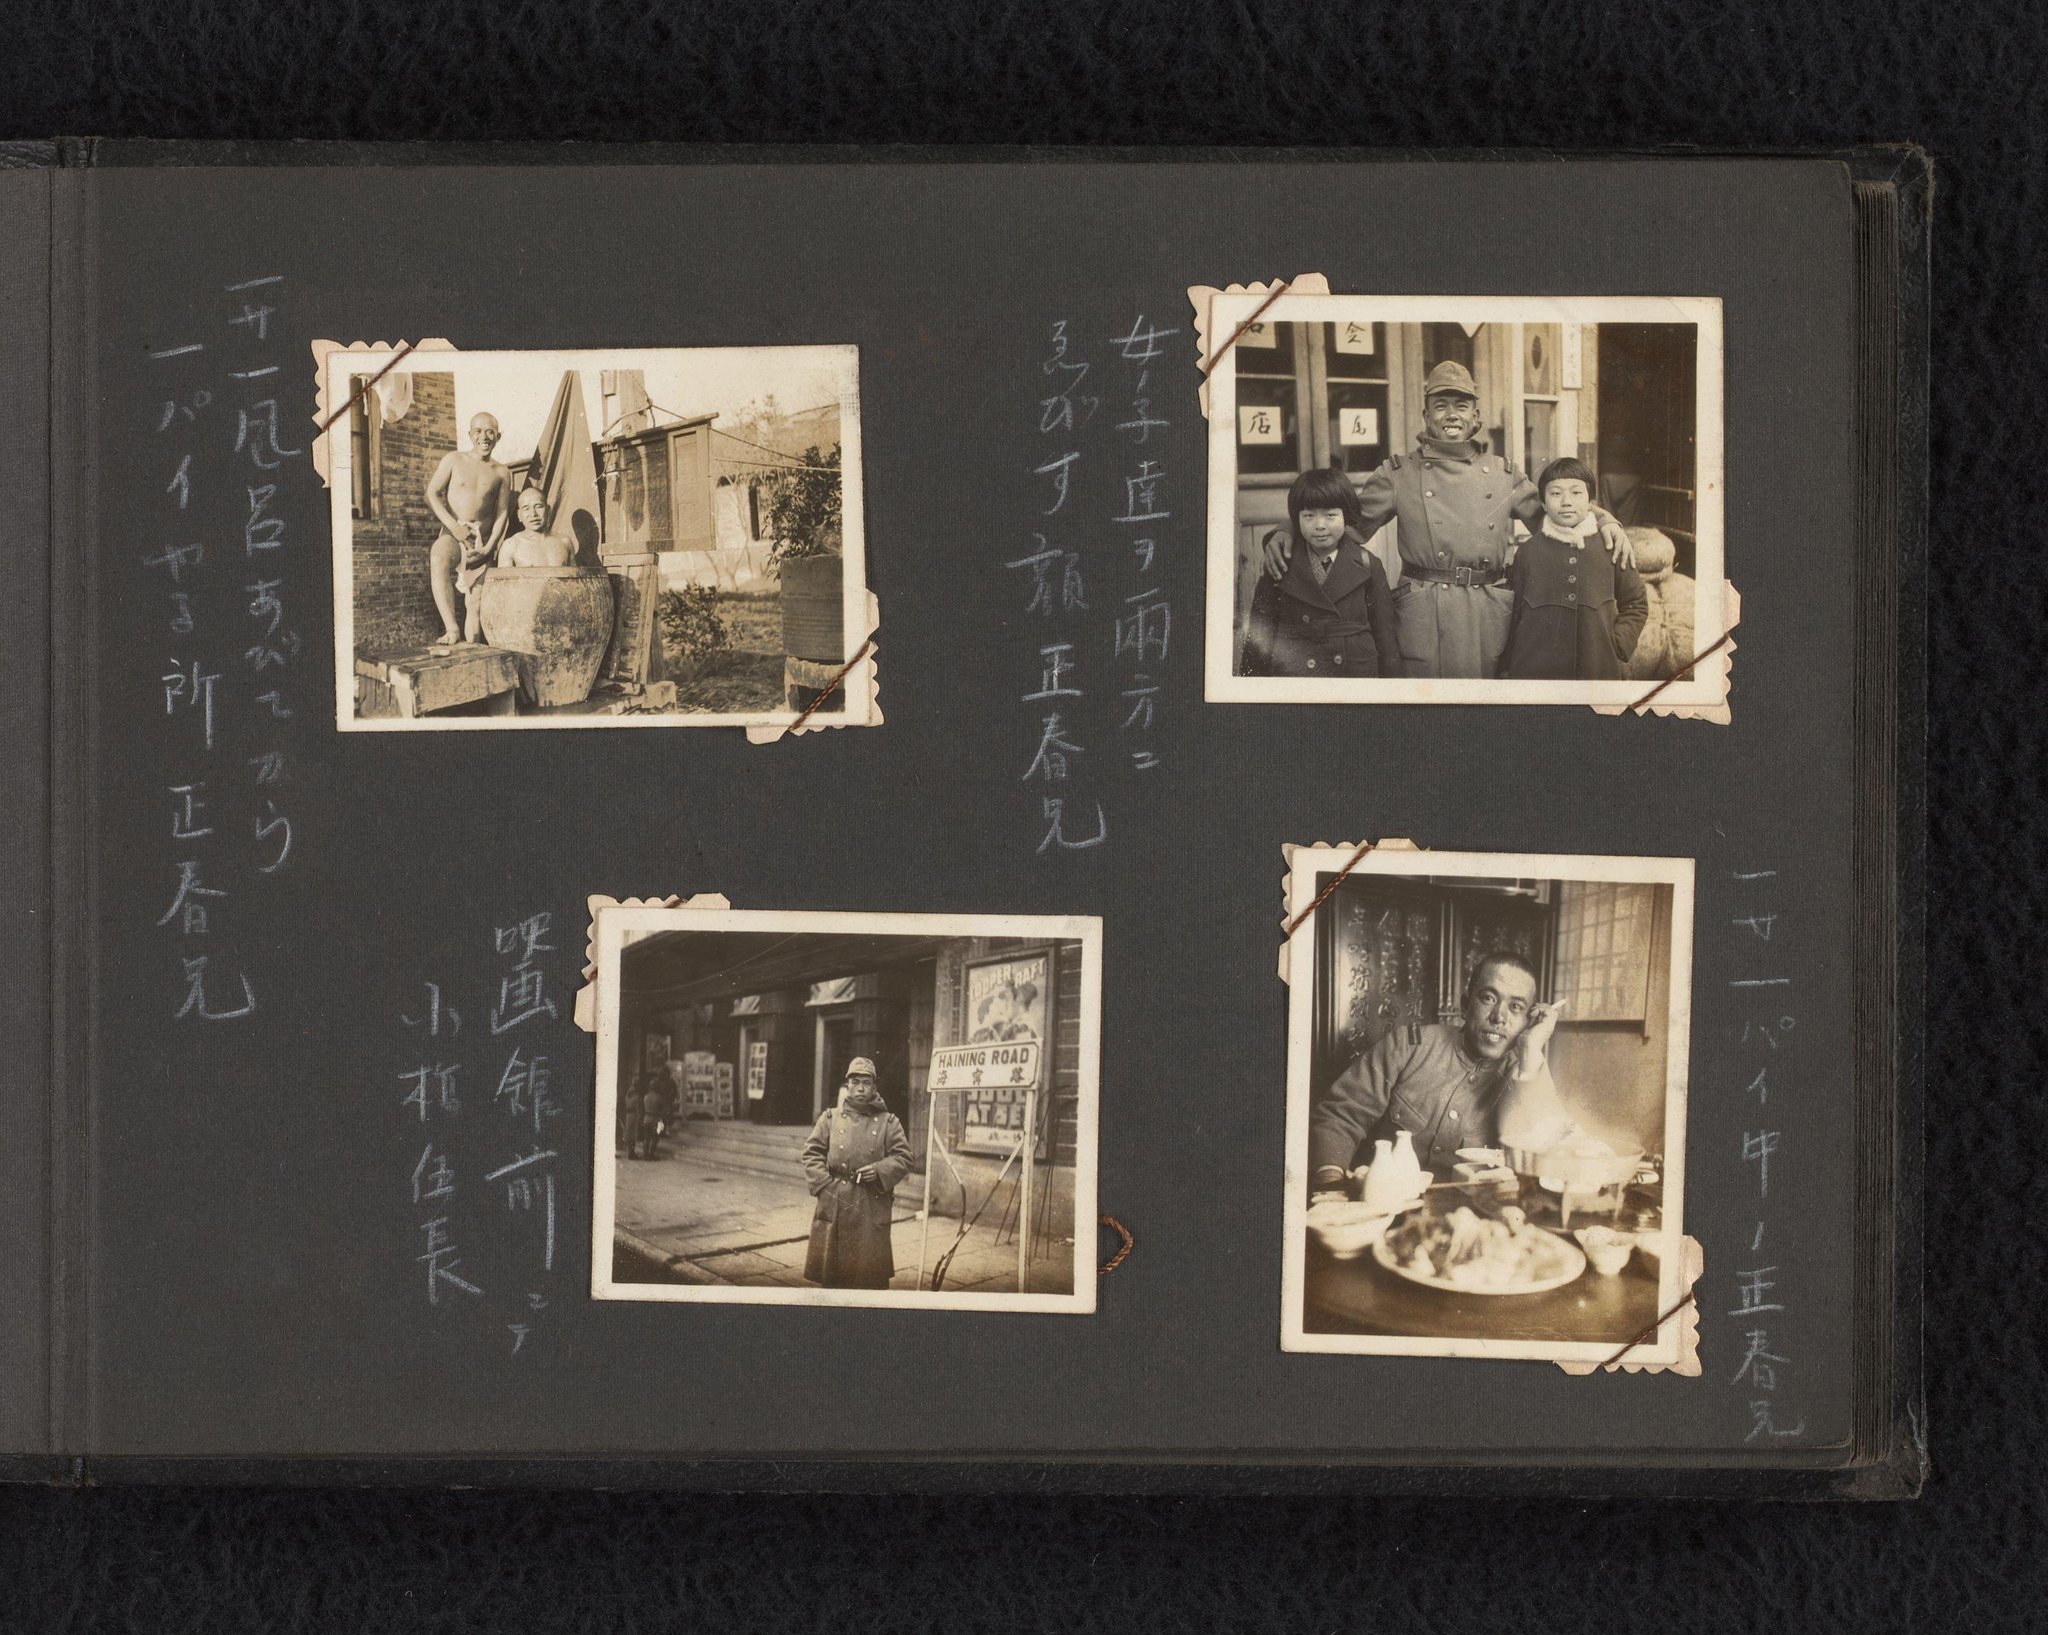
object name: album leaf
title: Japanse soldaten in hun vrije tijd, linksonder bij een filmtheater aan Haining Road in China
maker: Anonymous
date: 1937-1941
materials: paper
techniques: gelatin silver print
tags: theatre (building), taking a bath - aa - in the open air, the soldier; the soldier's life, restaurant, china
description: Deze foto's zijn onderdeel van een album.